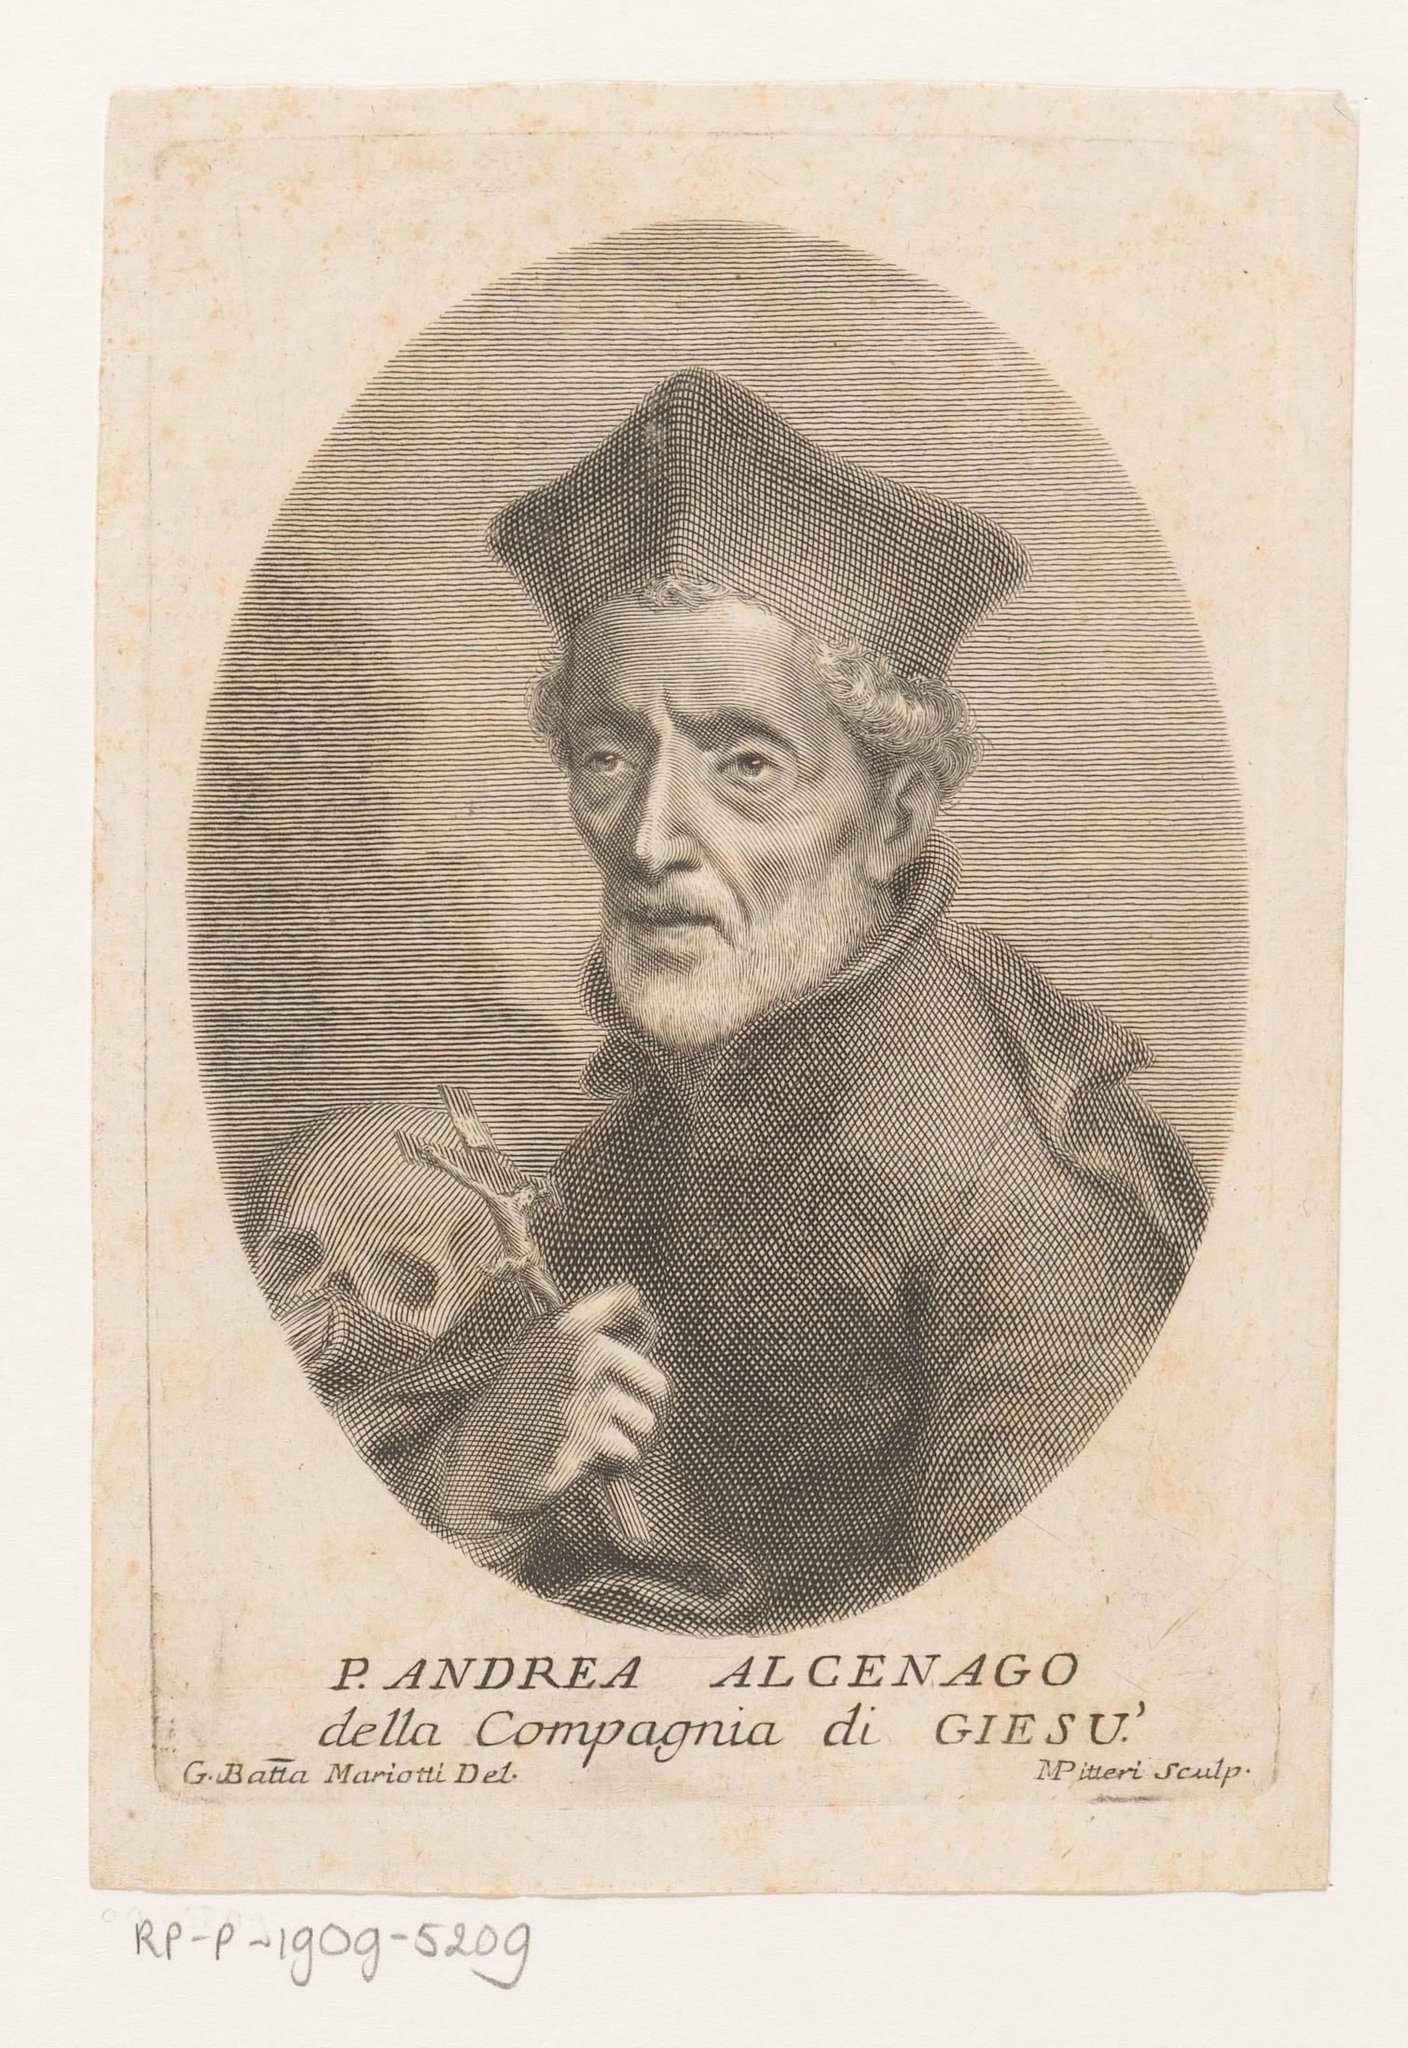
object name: print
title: P. Andrea Alcenago della Compagnia di Giesu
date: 1712-1786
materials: paper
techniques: engraving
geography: italy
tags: historical persons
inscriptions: collector's mark: Lugt 2228